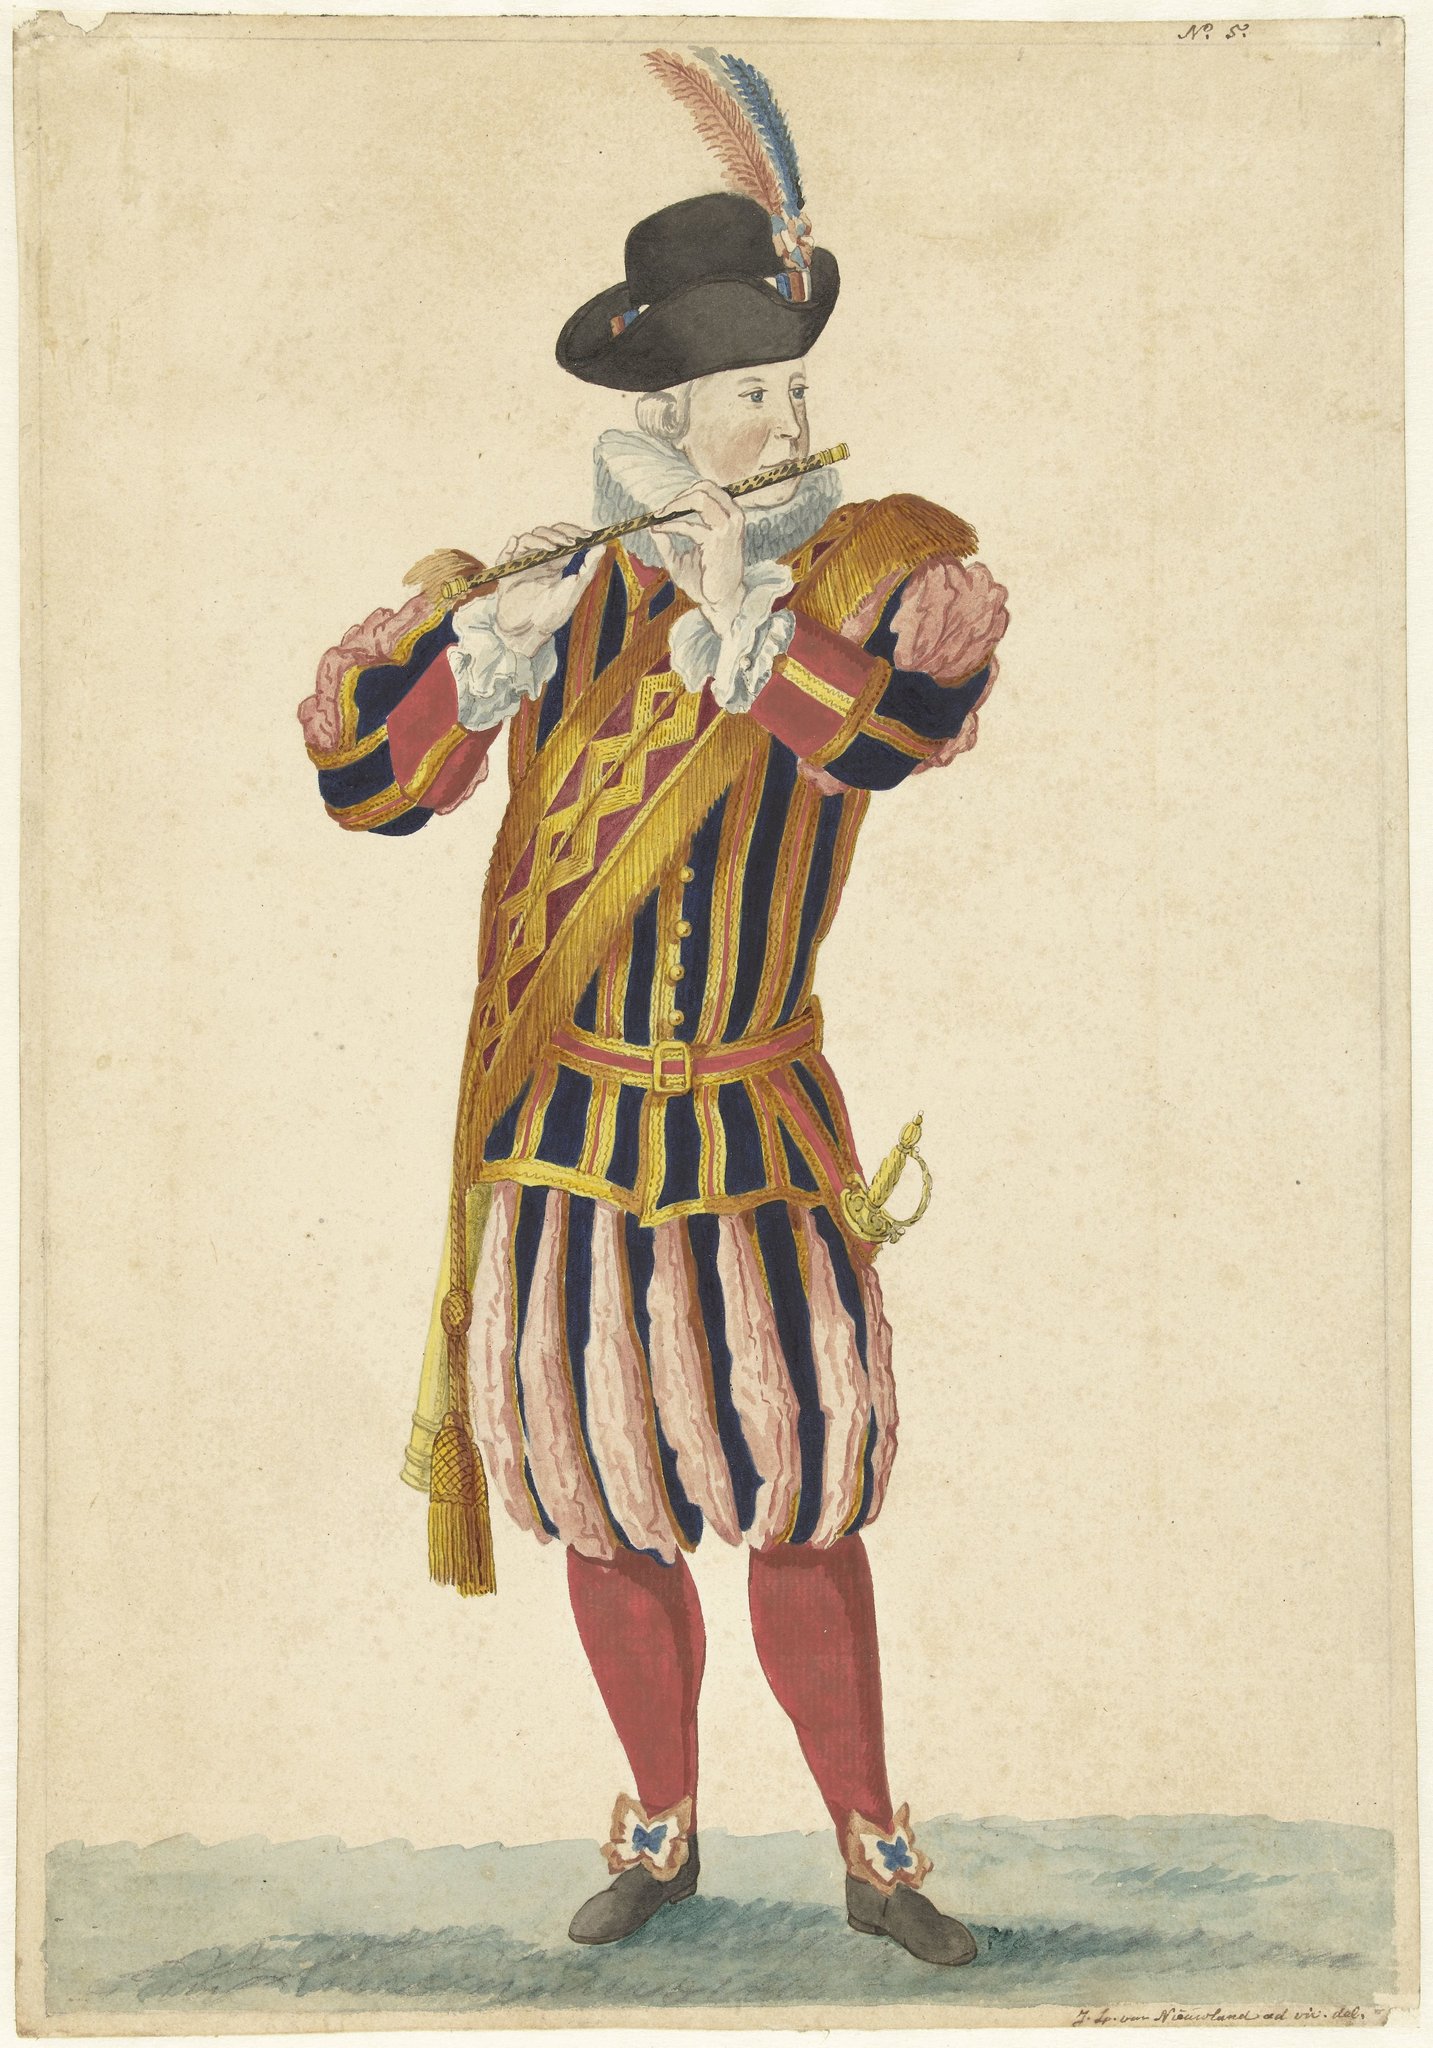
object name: kostuumstudie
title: A Fifer from the Cent Suisses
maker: isaac lodewijk la fargue van nieuwland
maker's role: draughtsman, painter, print maker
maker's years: 1726-1805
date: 1766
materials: ink, paper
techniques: brush, pen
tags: william v (prince of orange)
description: Blad 3 uit serie van 24 tekeningen met leden van de hofhouding van stadhouder Willem V.